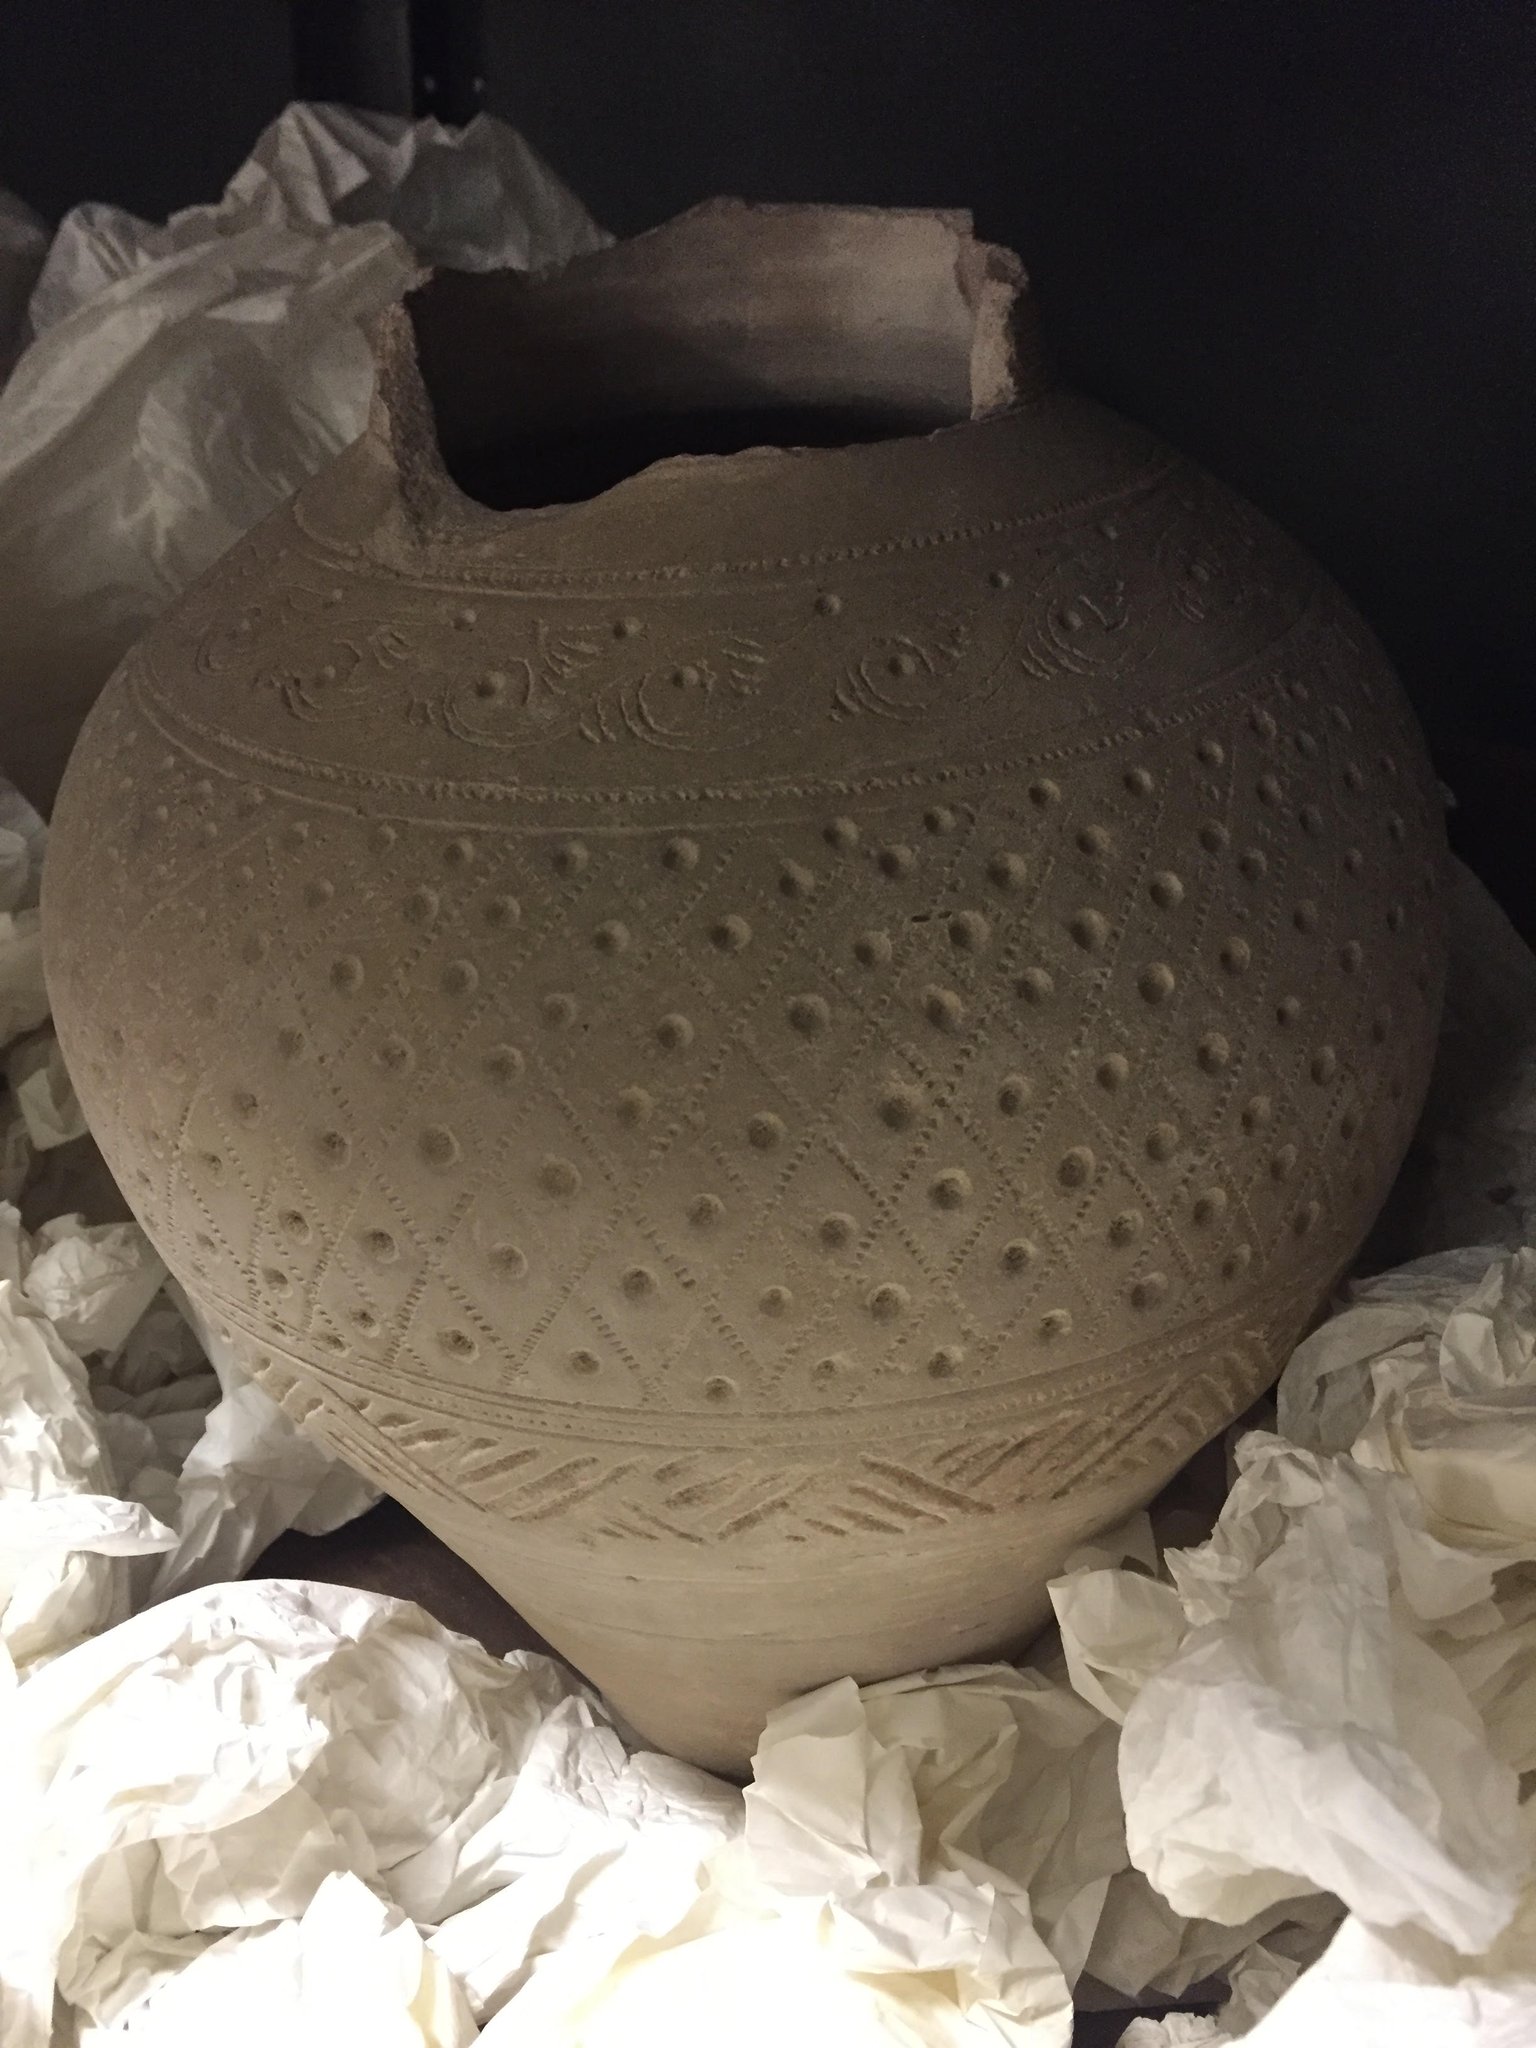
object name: jar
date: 1001-1100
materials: earthenware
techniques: incising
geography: iran